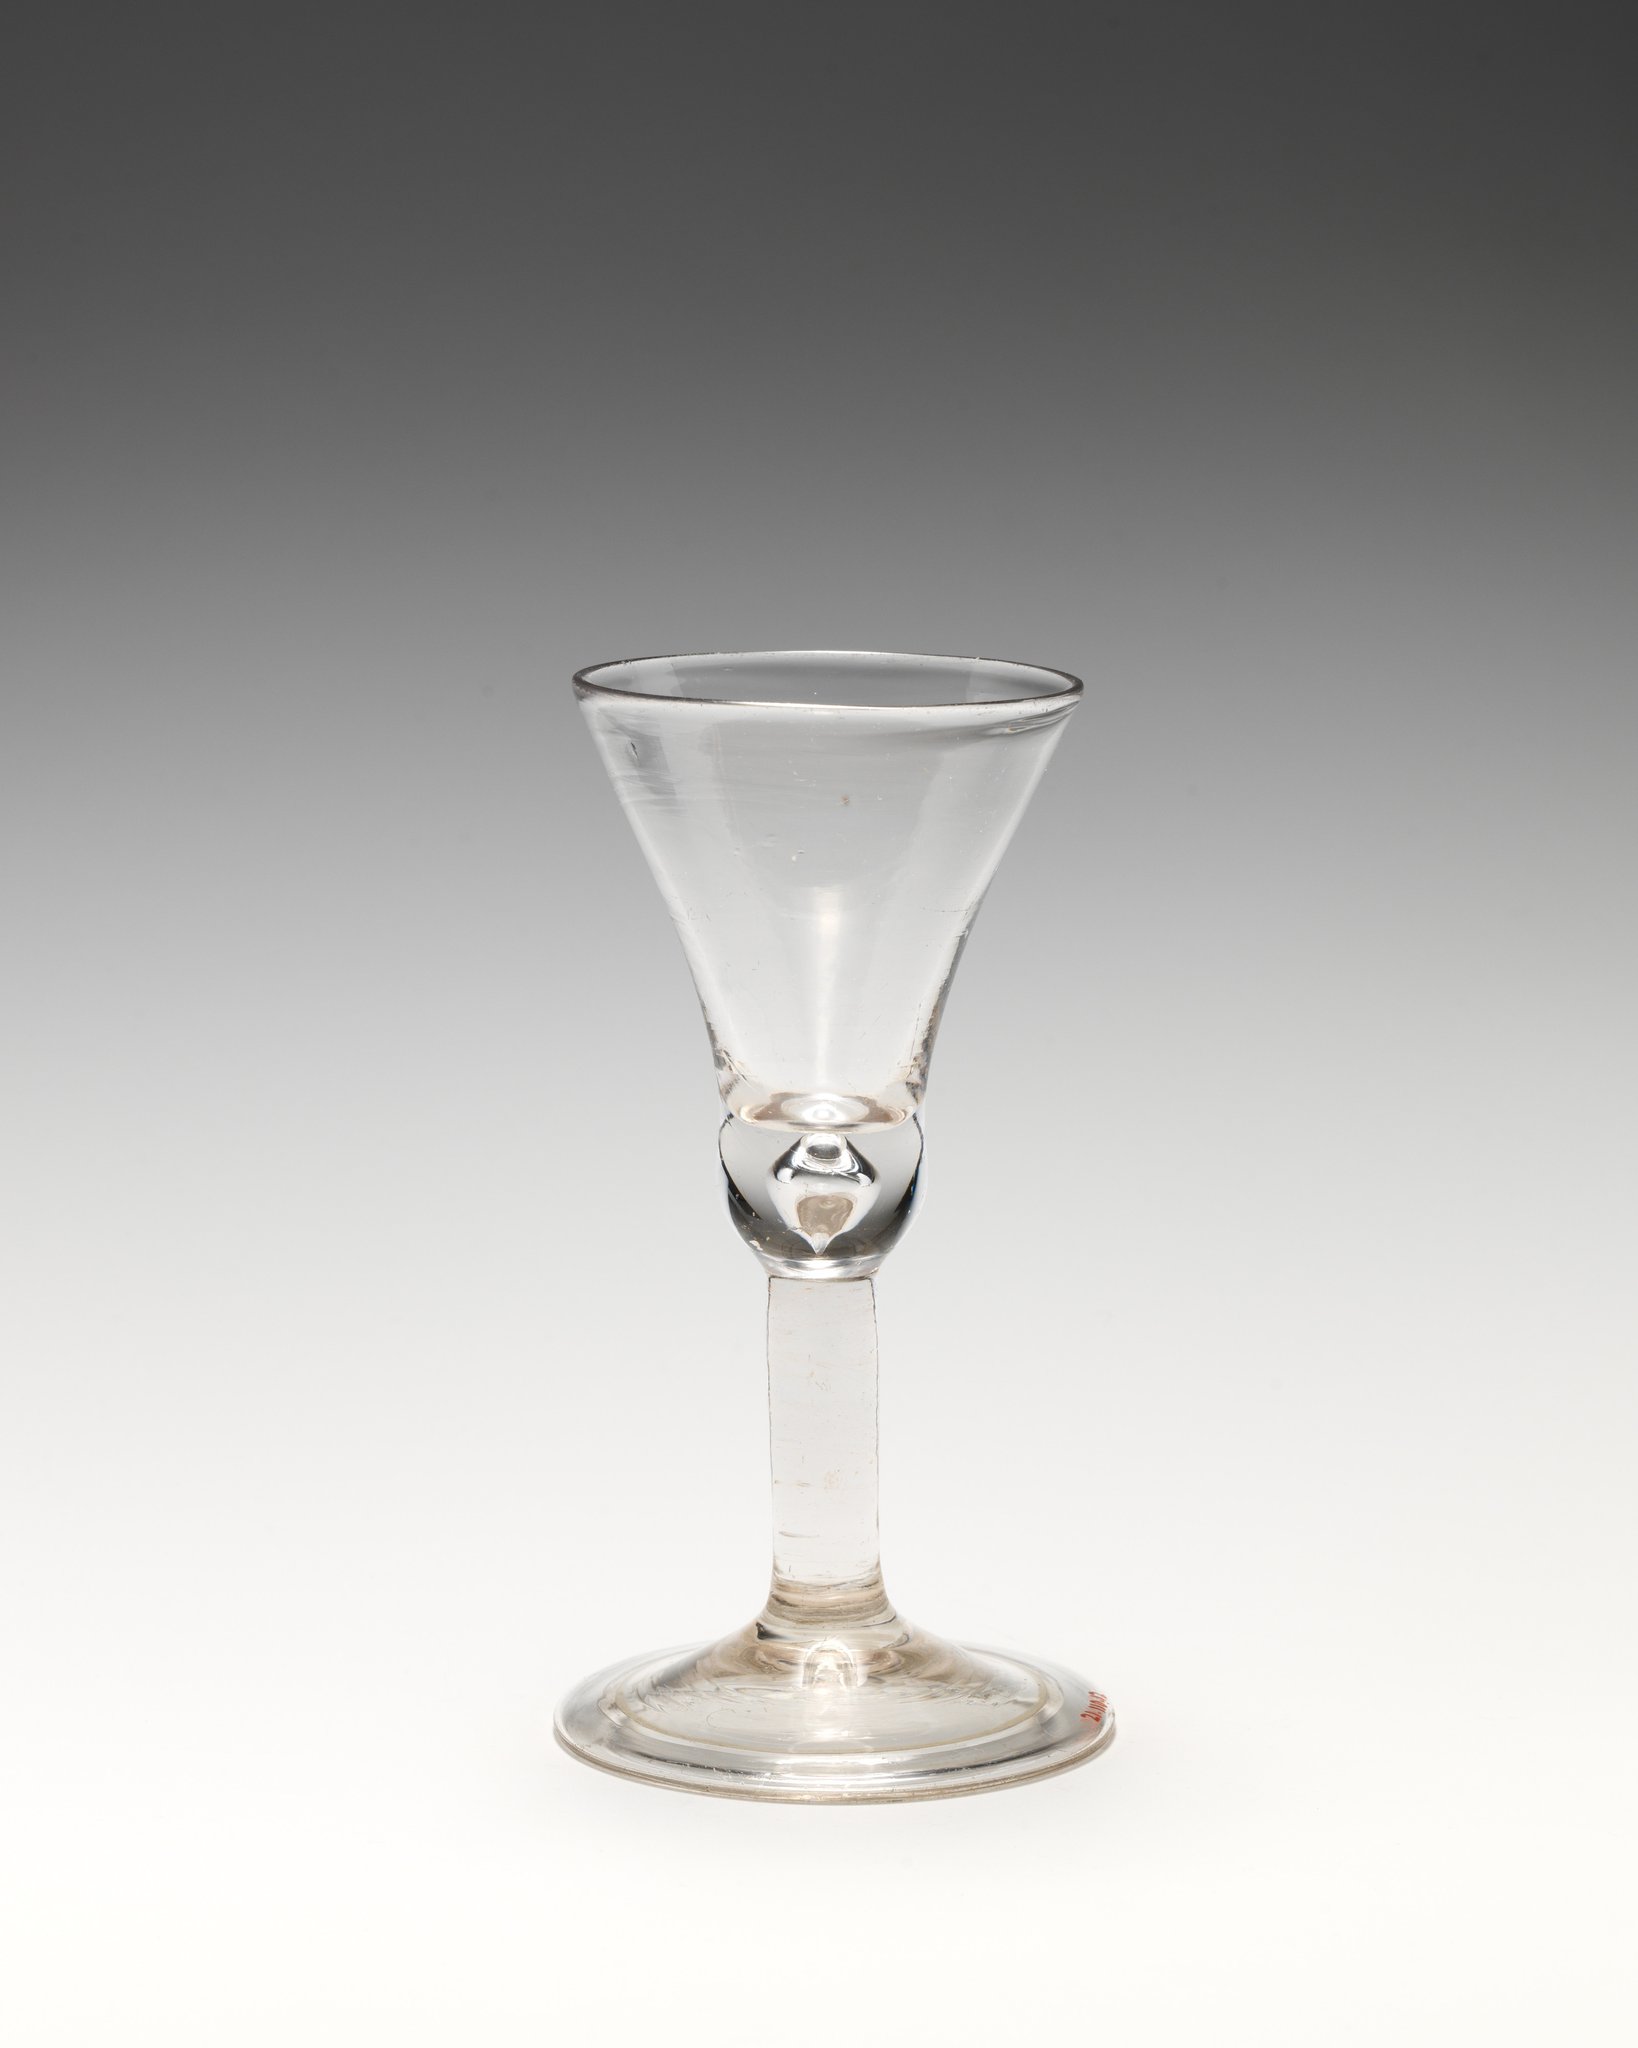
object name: wineglass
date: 1701-1750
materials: glass